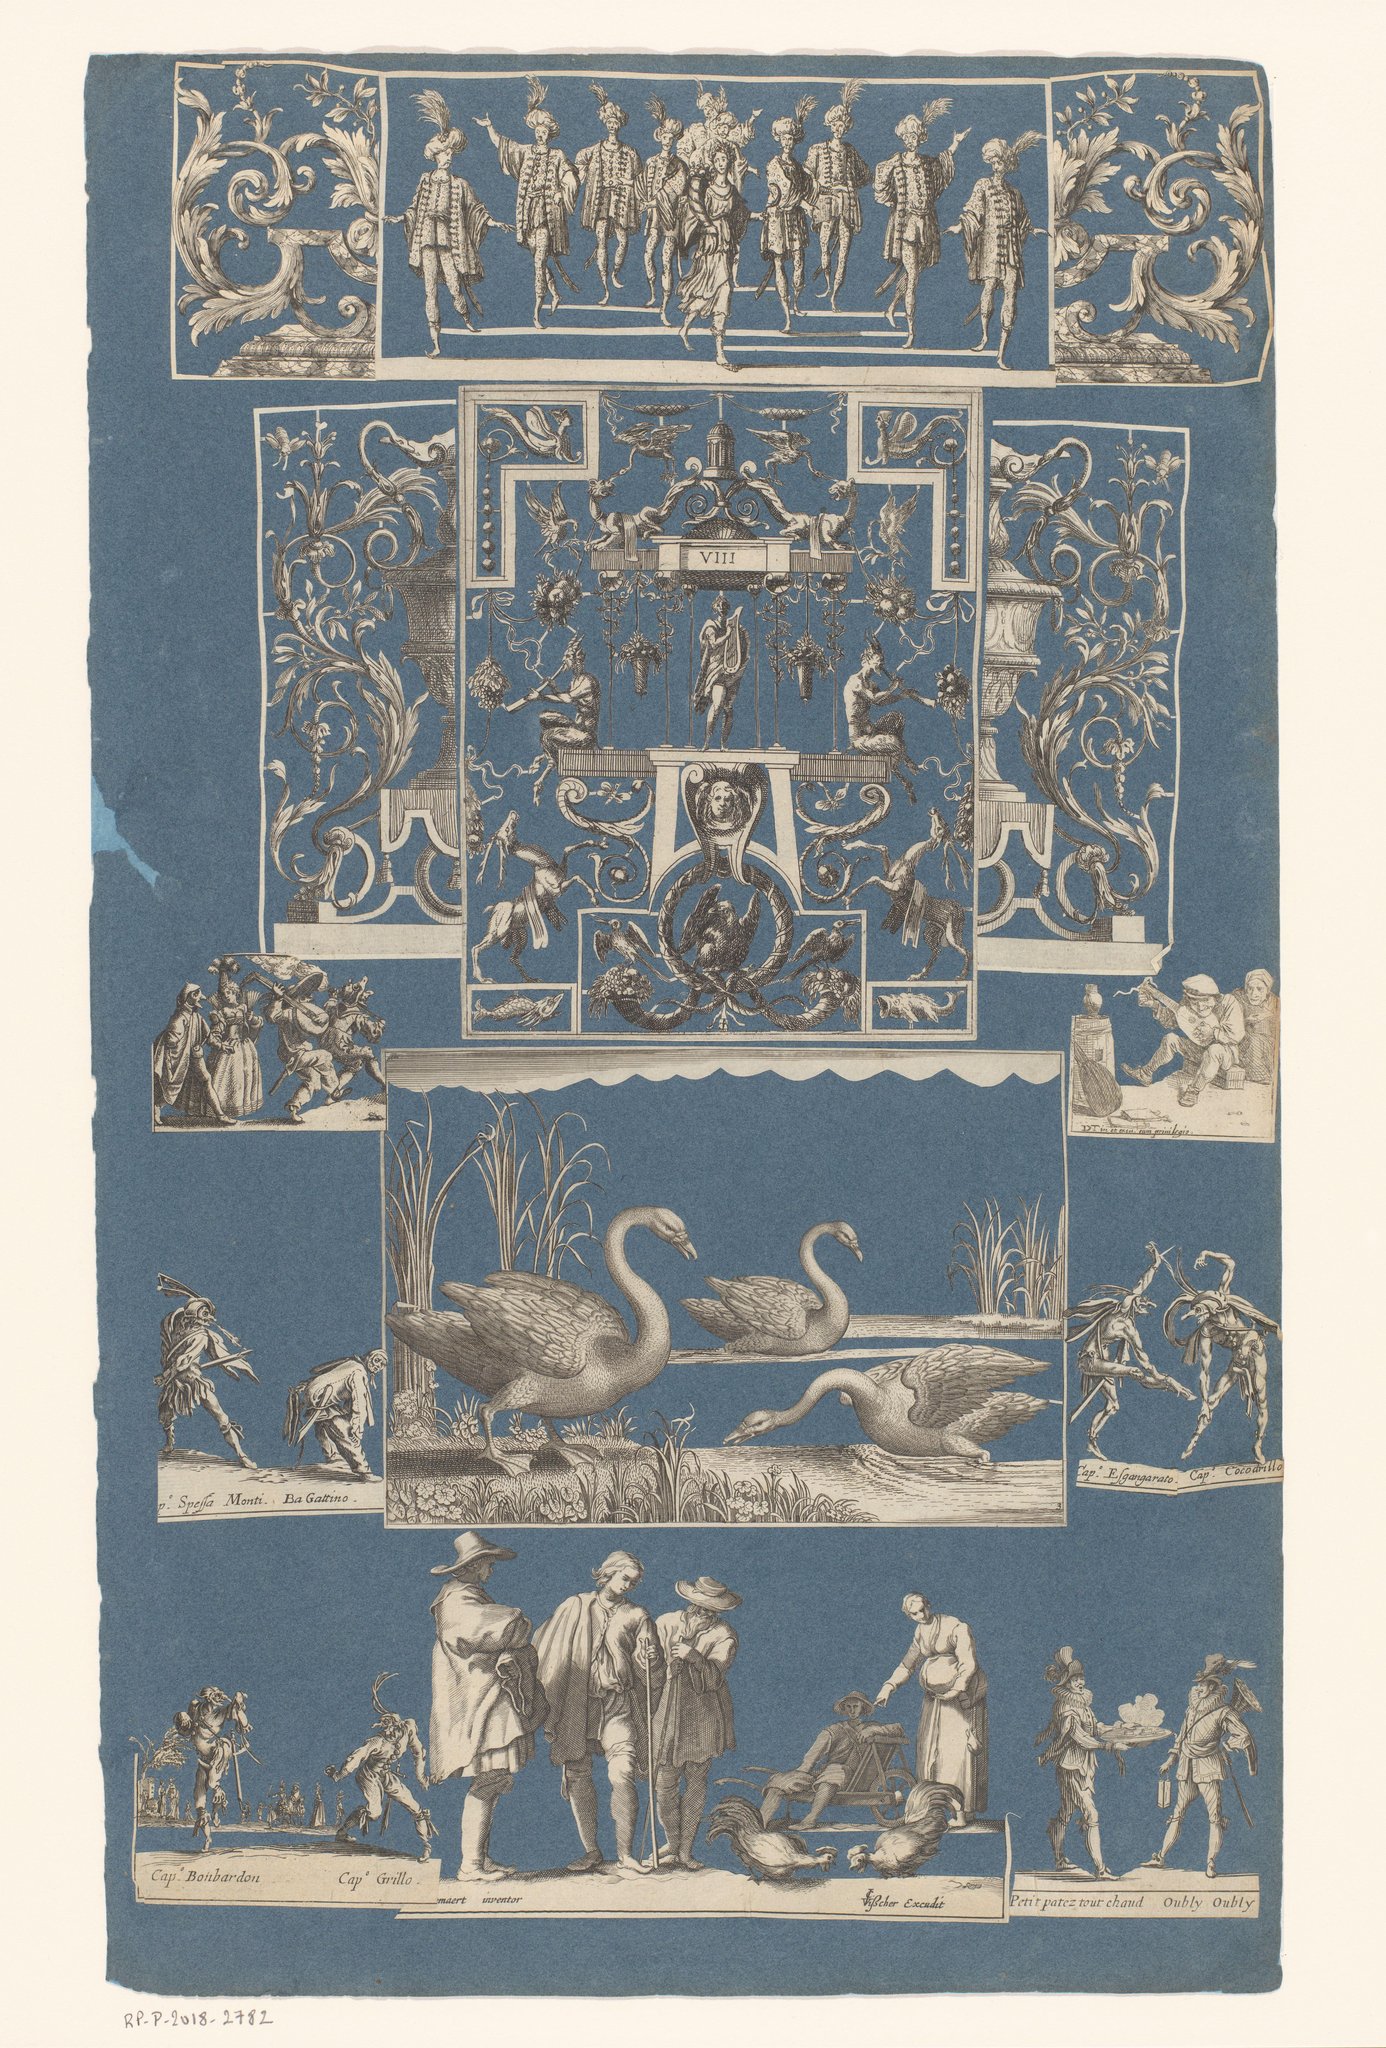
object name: print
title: Collage van uitgeknipte prenten geplakt op een albumblad van blauw papier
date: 1680-1720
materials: paper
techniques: engraving, etching, snipping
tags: water-birds: swan, morris dance, 'mauriskentanz'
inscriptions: collector's mark: Lugt 2228, collector's mark: Lugt 2760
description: Blauw albumblad beplakt met uitgeknipte prenten van verschillende prentmakers en ontwerpers.